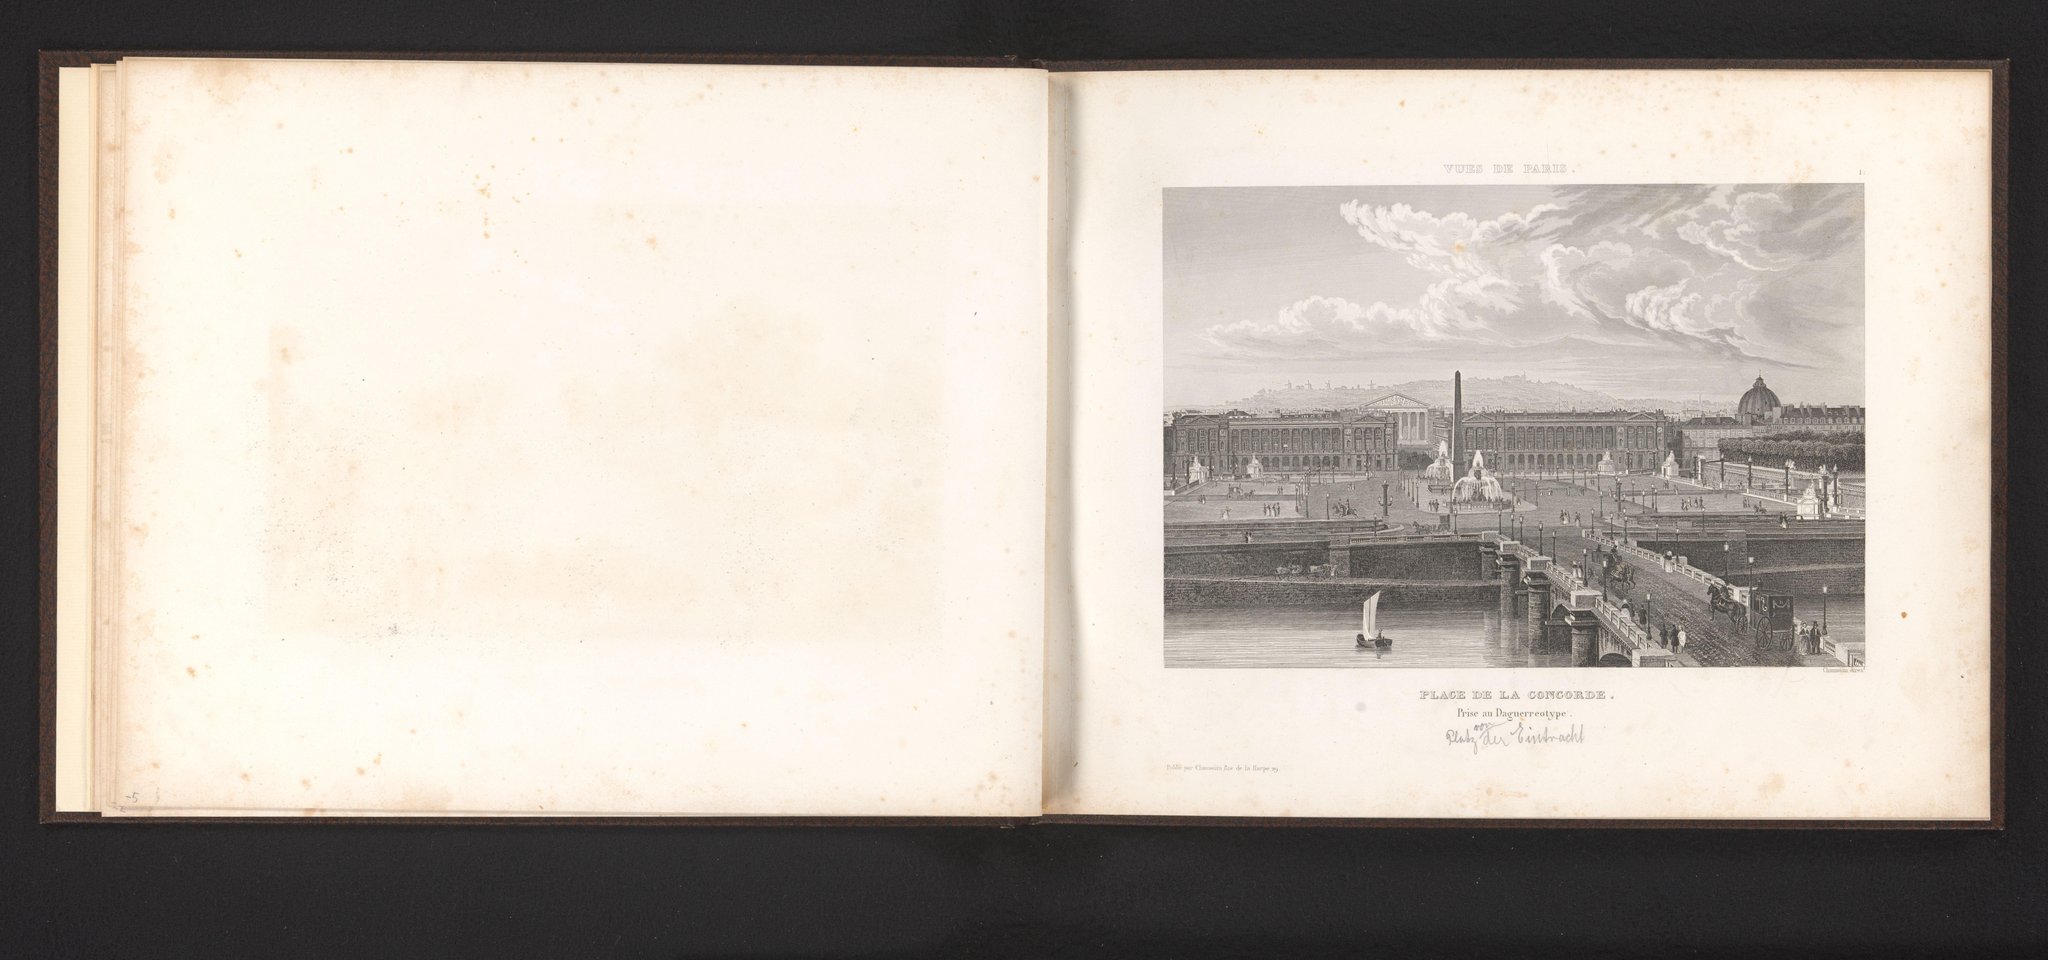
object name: page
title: Place de la Concorde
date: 1845-1850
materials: paper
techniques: engraving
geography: paris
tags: square, place, circus, etc.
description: Prent op zesde ongenummerde pagina na titelpagina. Prent gemaakt naar daguerreotypie.